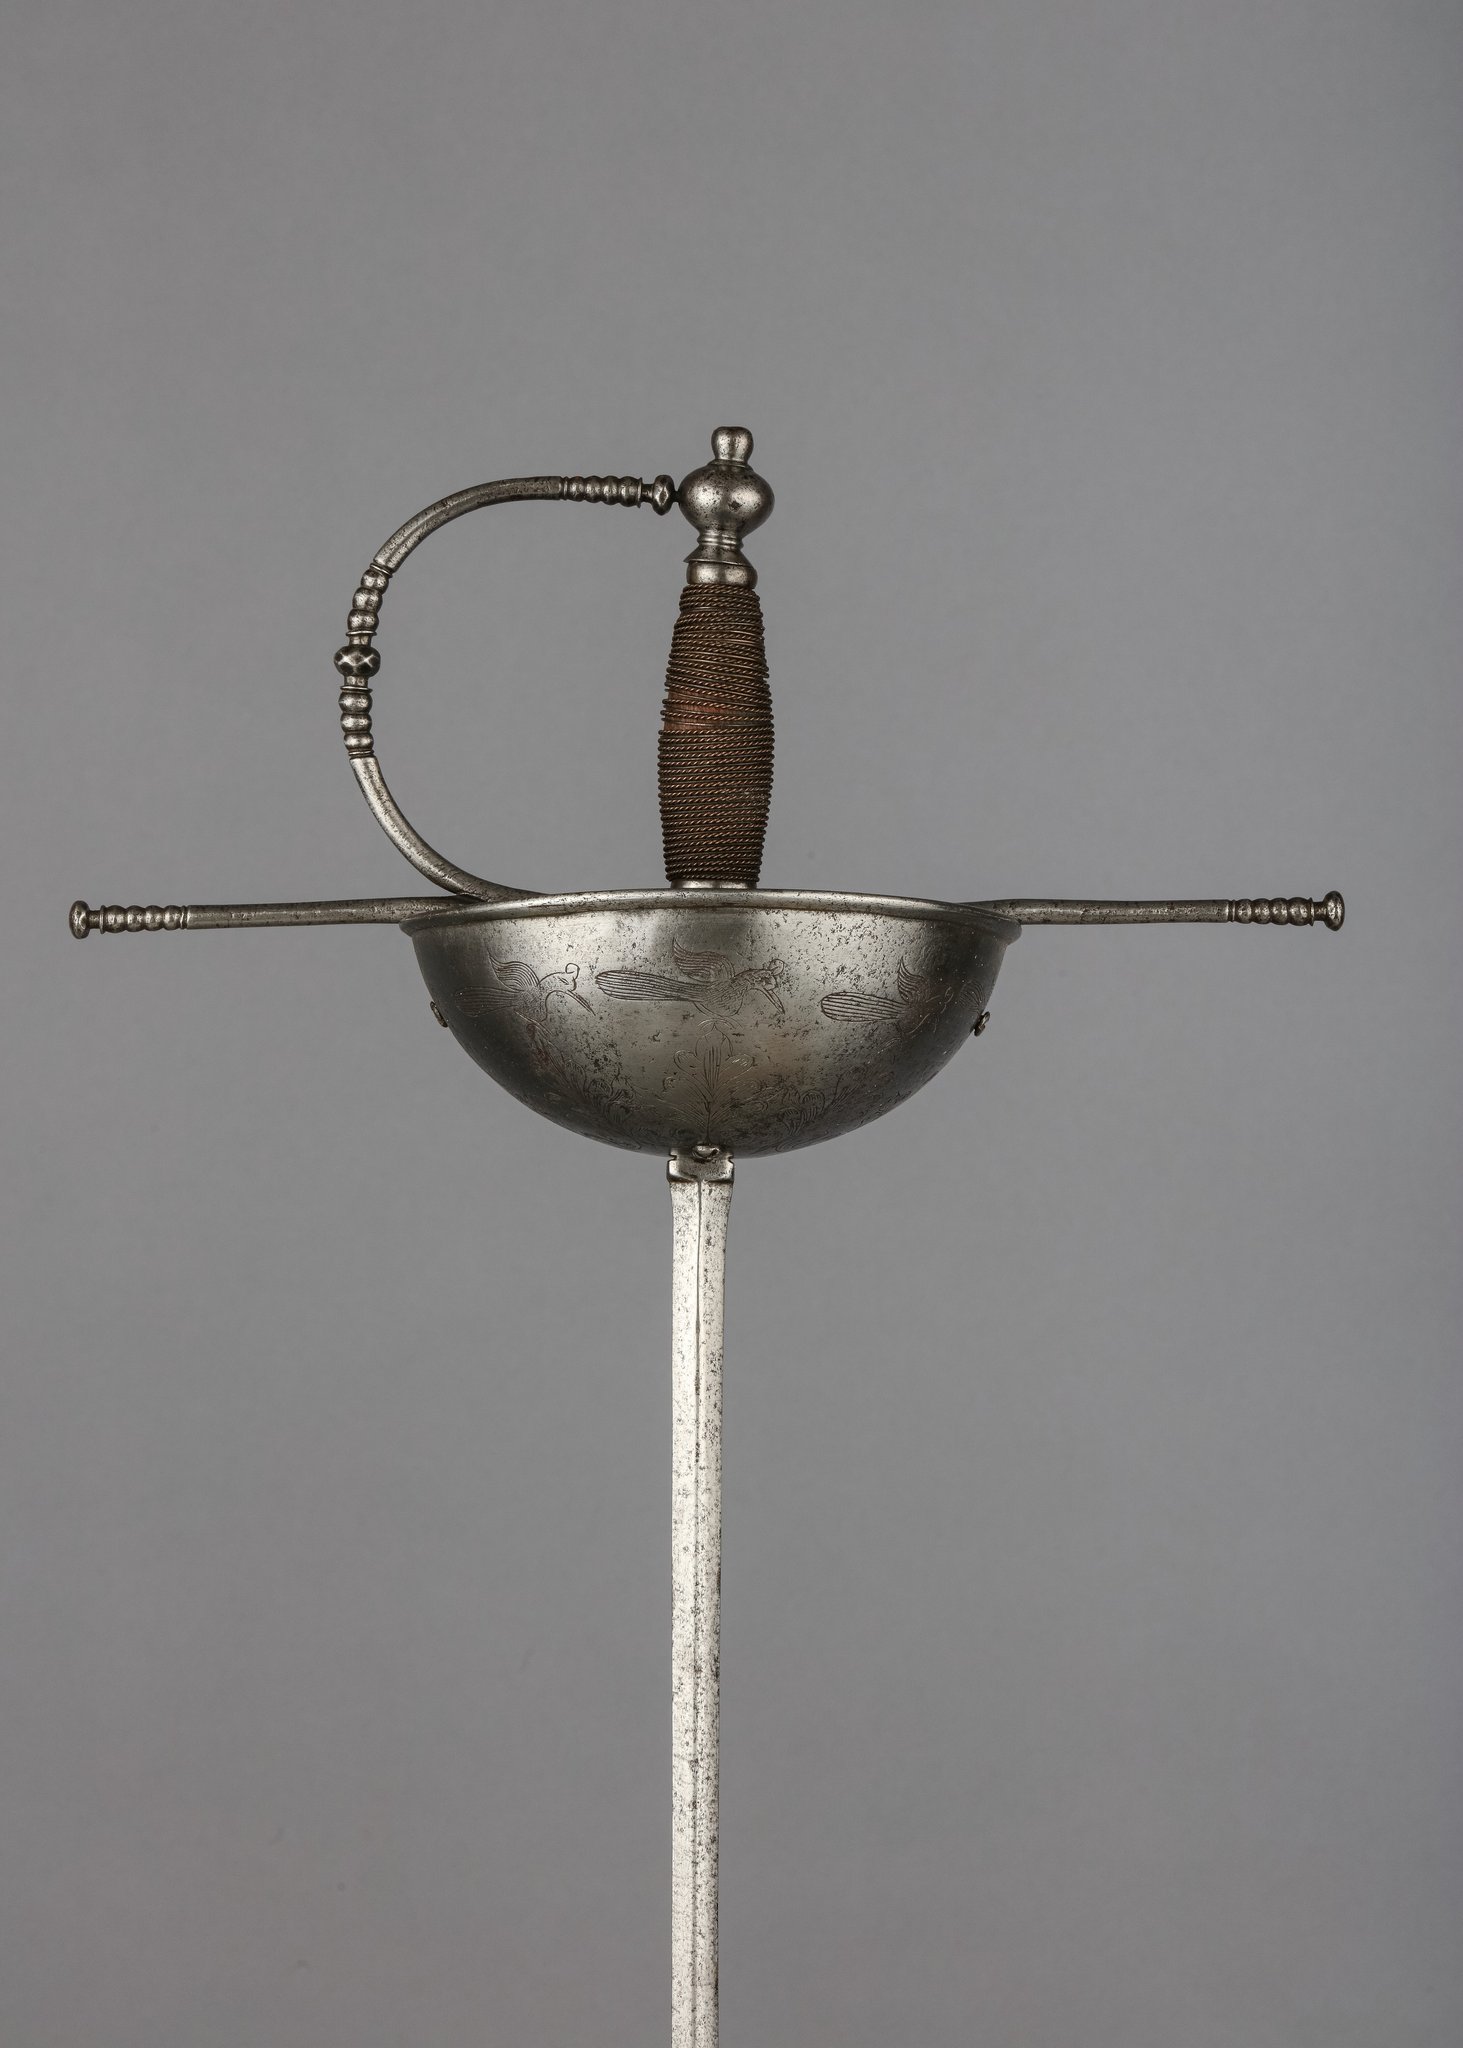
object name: cup hilted rapier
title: Cup-Hilted Rapier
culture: spanish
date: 1601-1700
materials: copper, steel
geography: spain